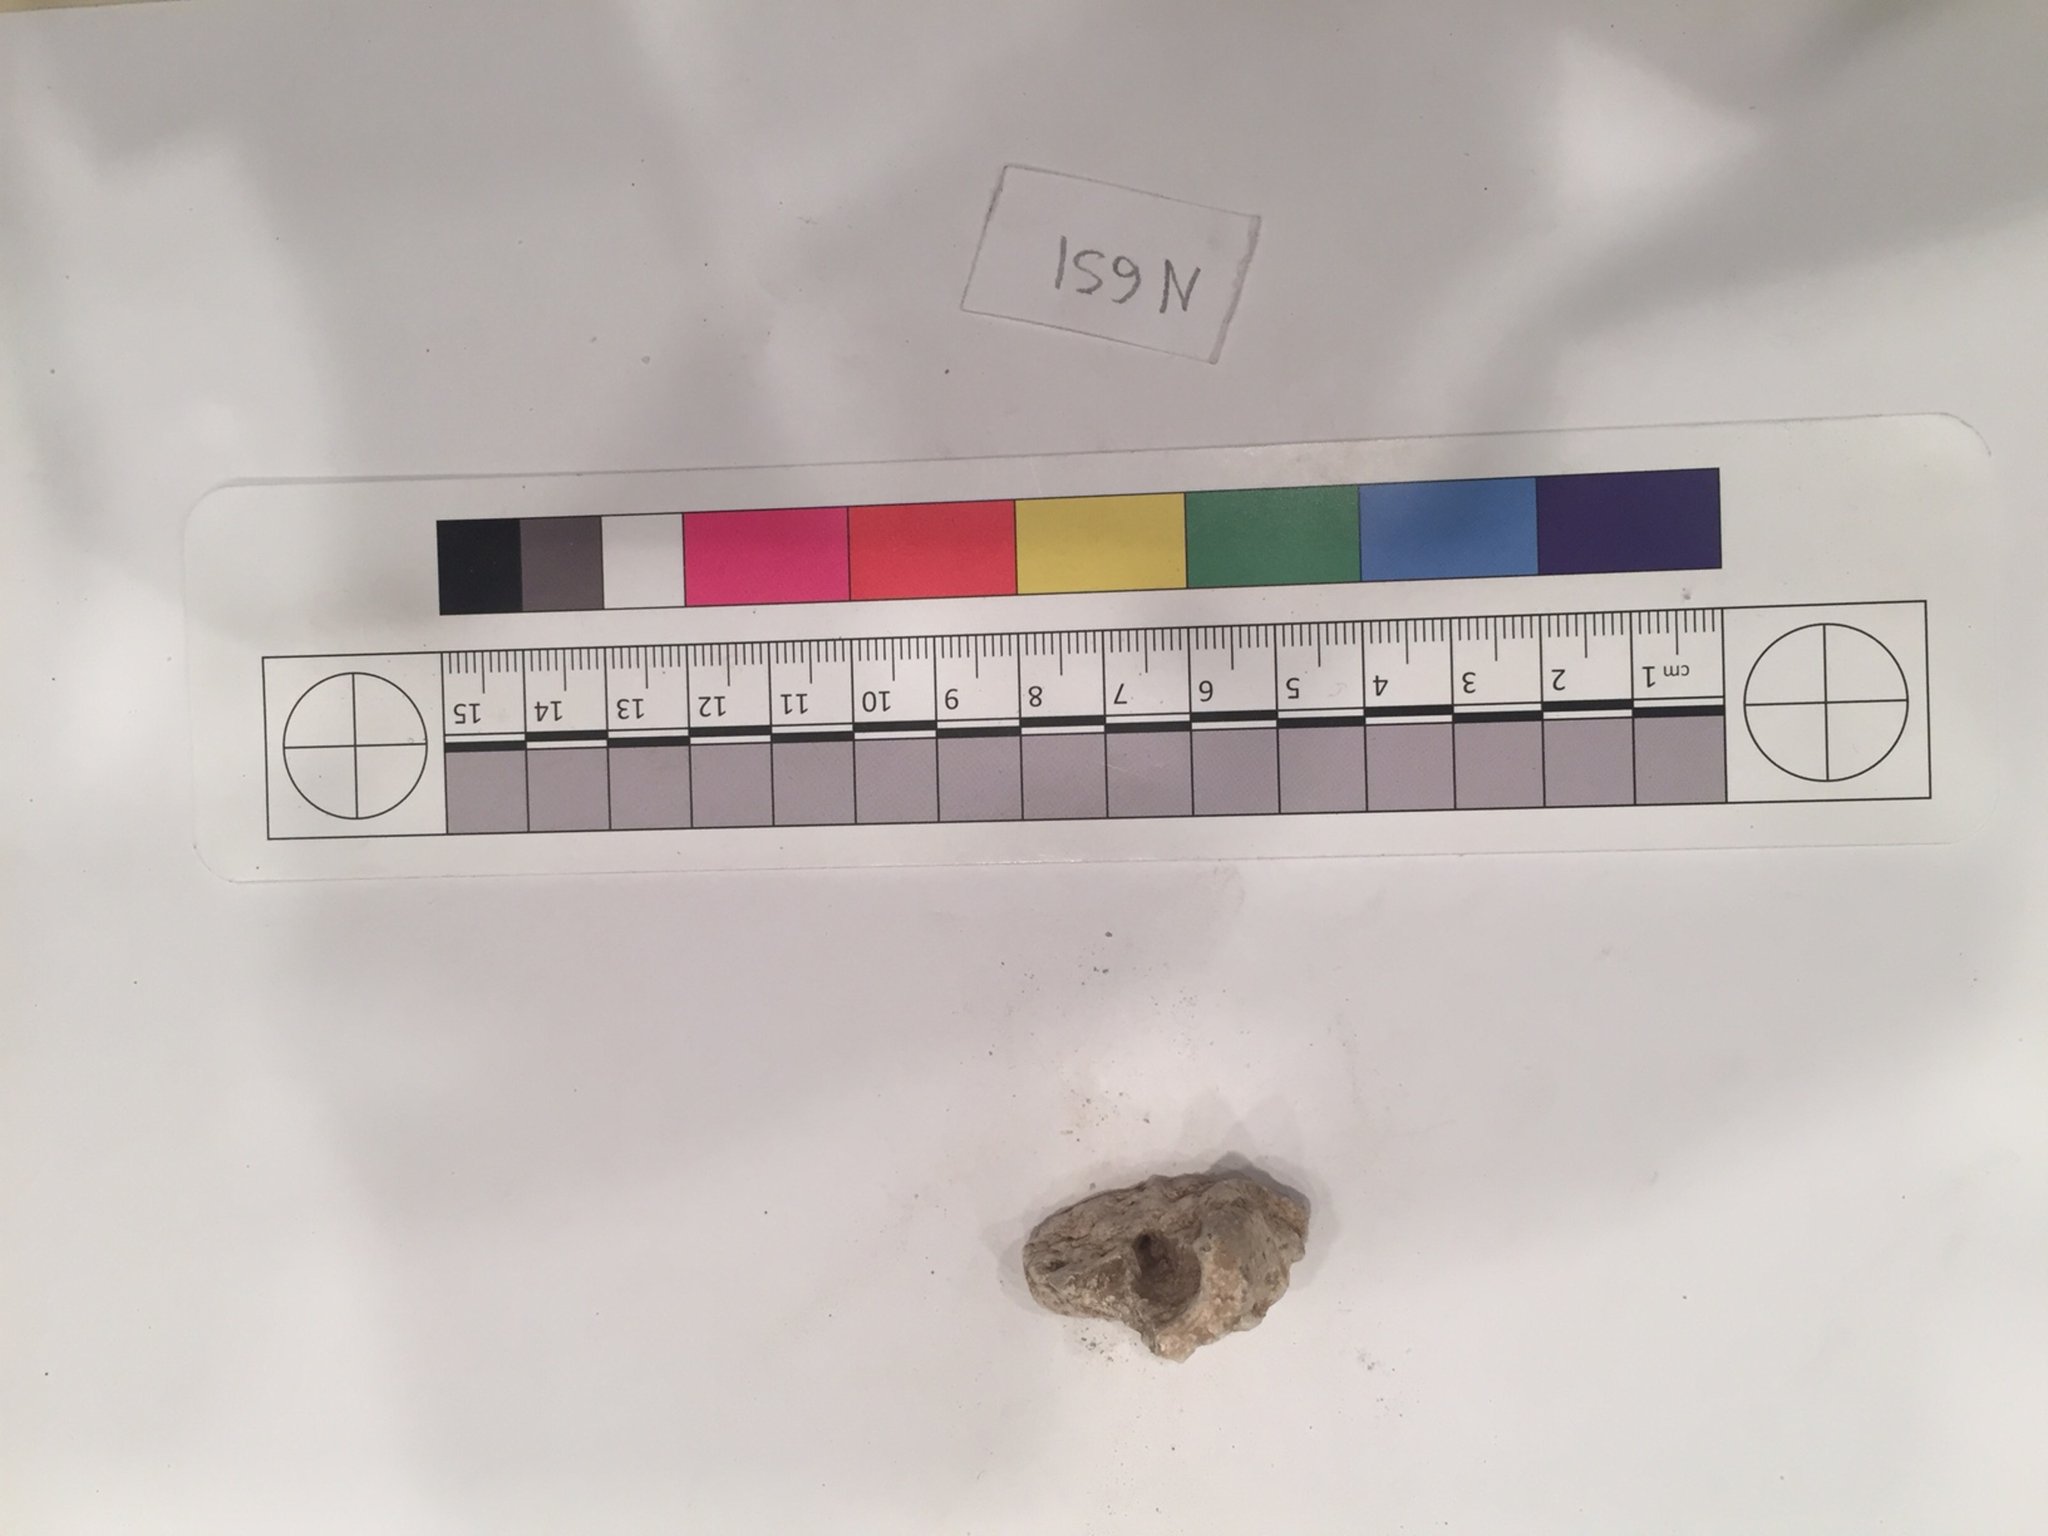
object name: fragment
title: Stucco Fragment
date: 701-1200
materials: plaster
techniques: carving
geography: iran